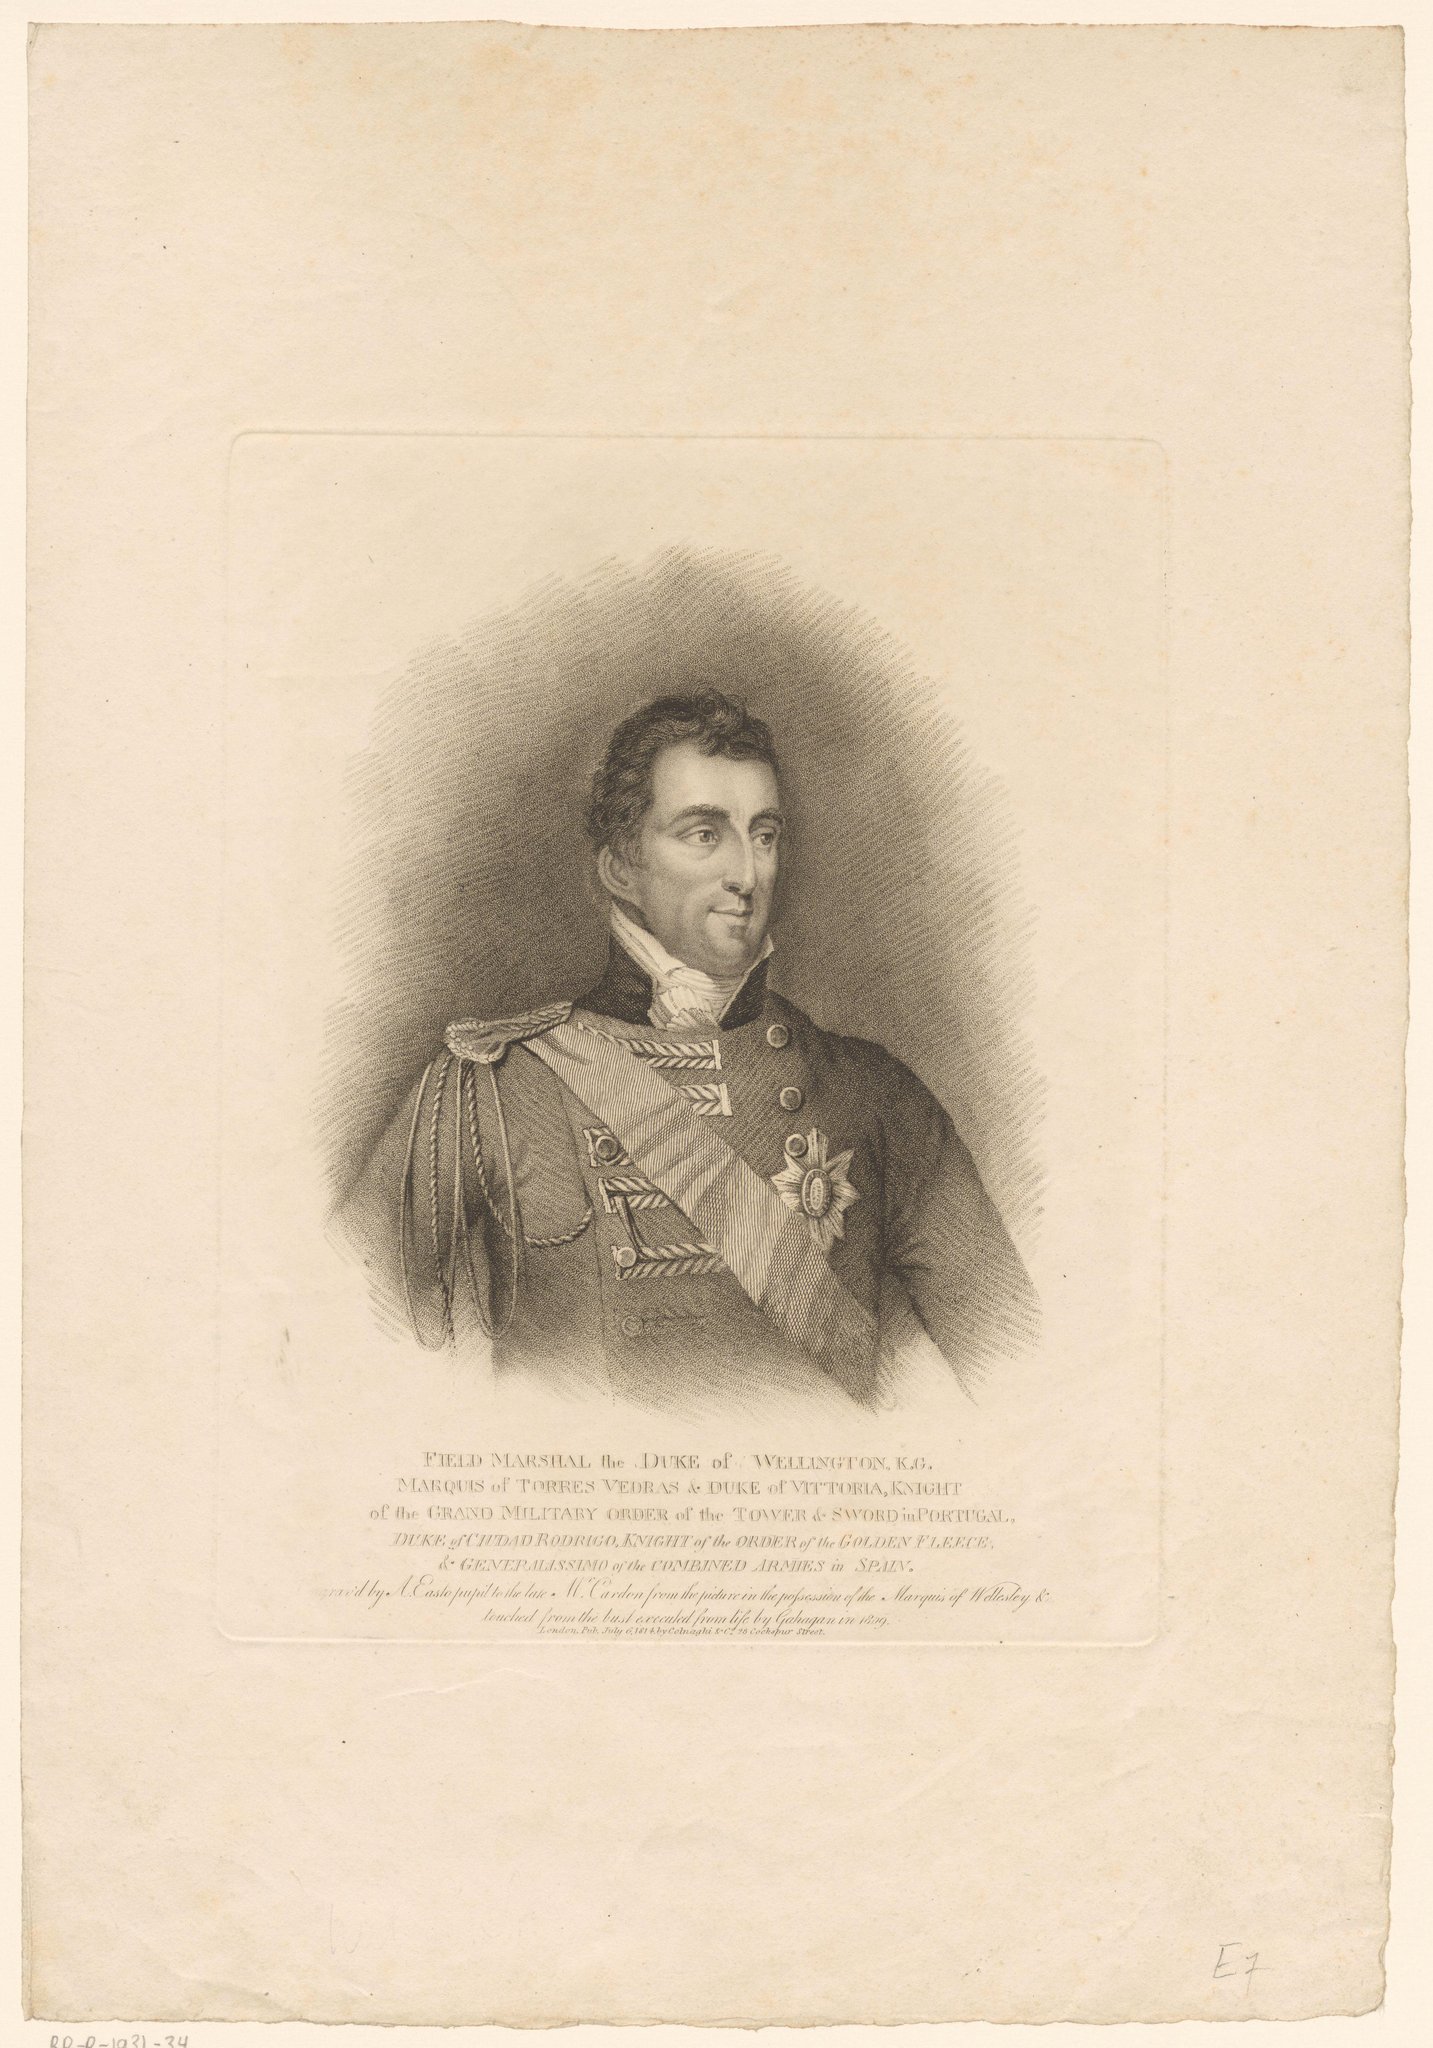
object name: print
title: Field Marshal the Duke of Wellington, K.G.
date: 1814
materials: paper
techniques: etching, roulette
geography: london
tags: walmer castle, arthur wellesley of wellington, commander-in-chief, general, marshal, historical persons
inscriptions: collector's mark: Lugt 2228